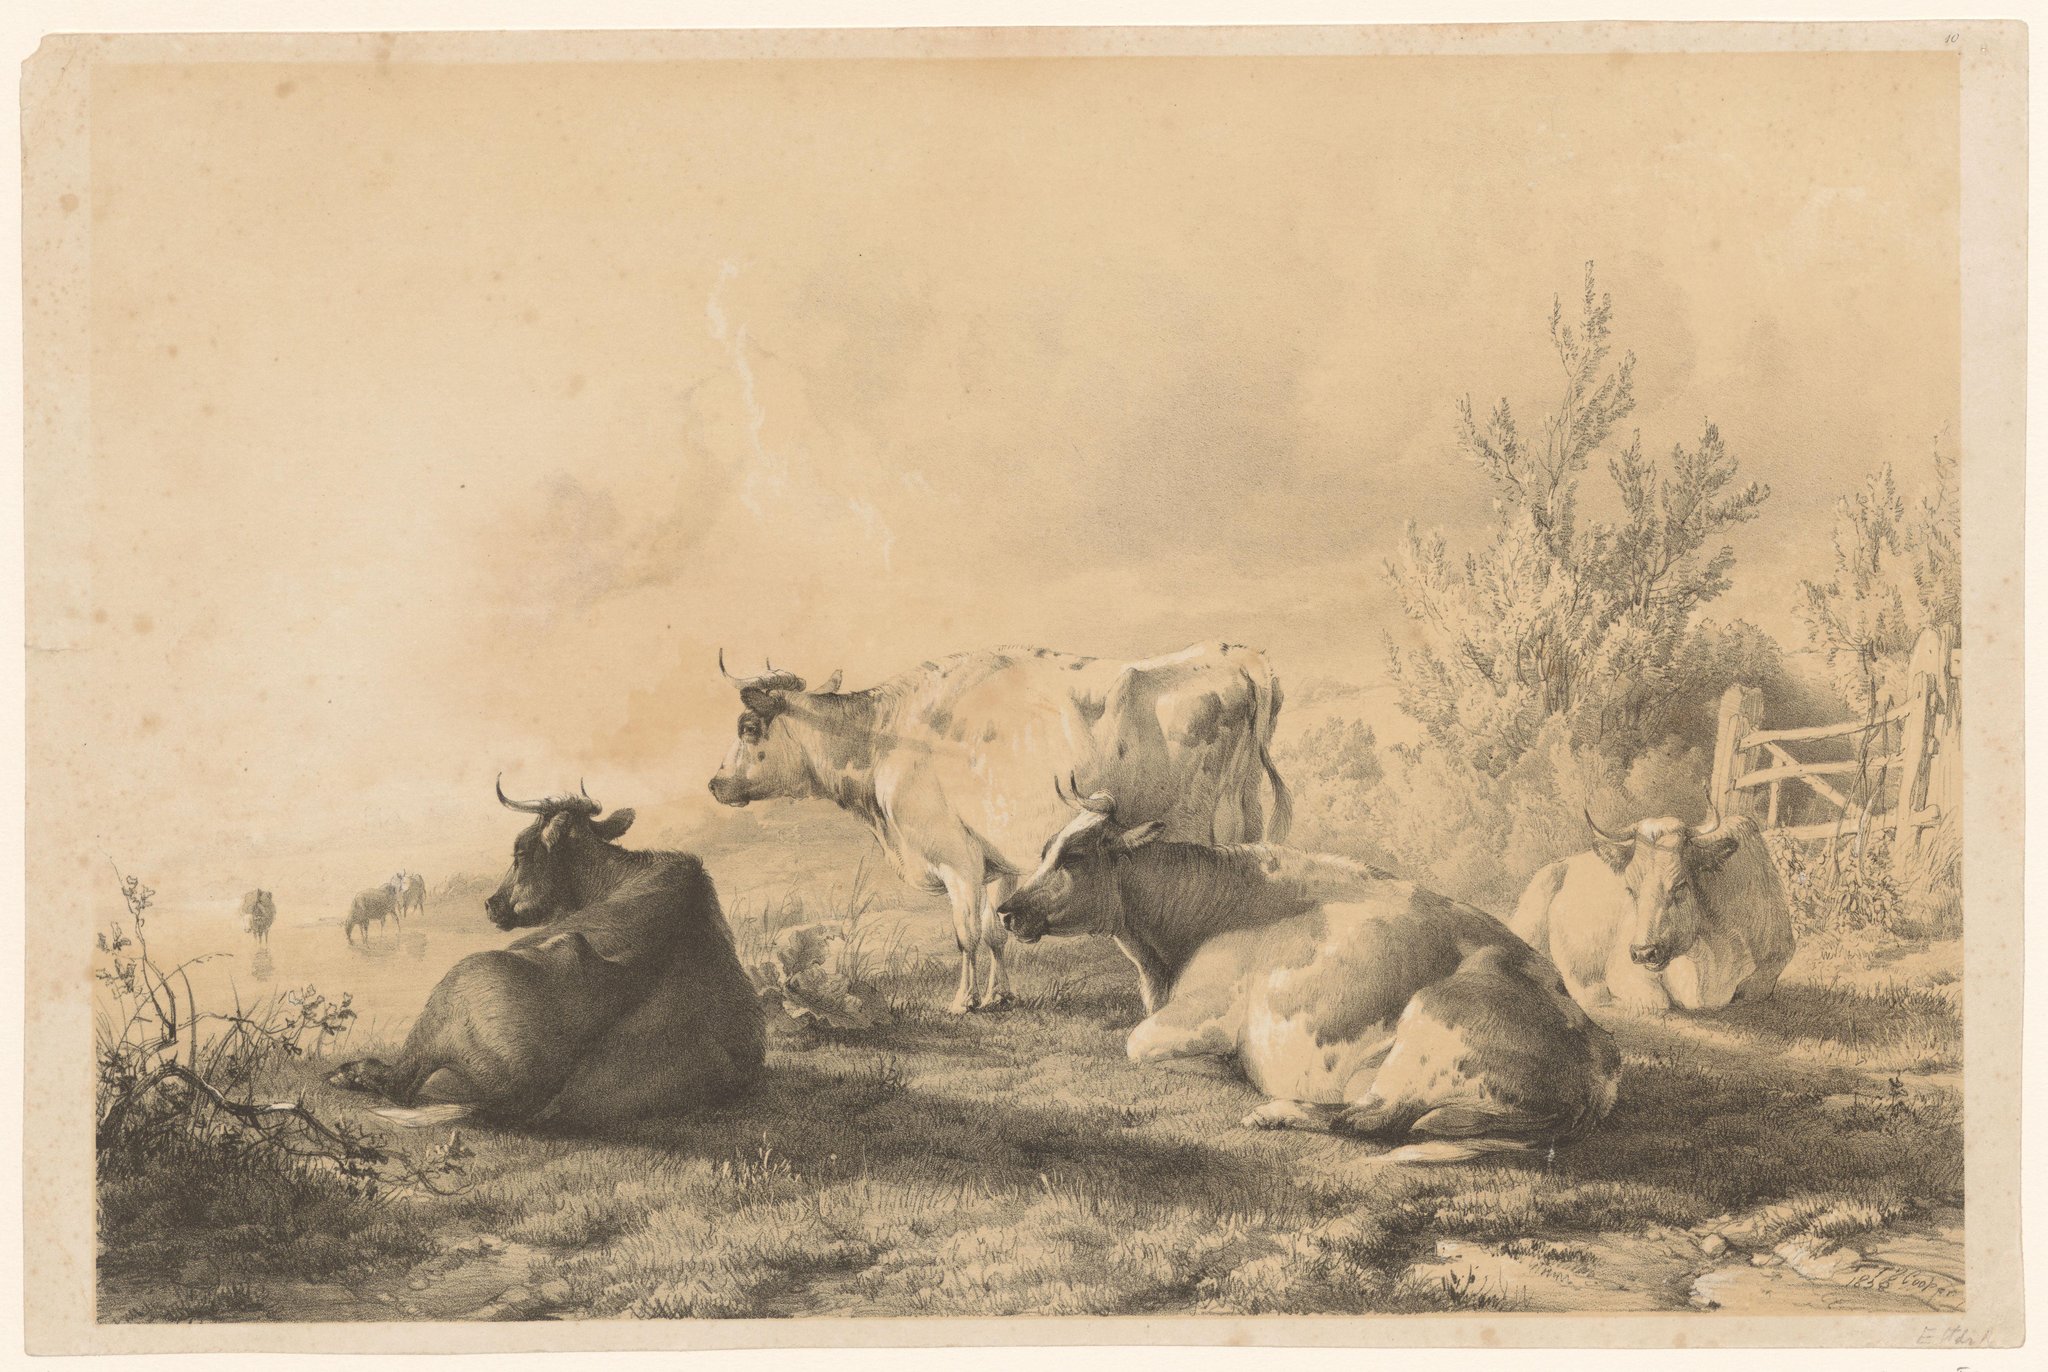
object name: print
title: Landschap met koeien aan een water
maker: thomas sidney cooper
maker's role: print maker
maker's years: 1803-1902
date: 1838-1839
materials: paper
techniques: tone lithography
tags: landscapes with waters, waterscapes, seascapes (in the temperate zone), bovine cattle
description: Prent maakt waarschijnlijk deel uit van de serie 'Groups of cattle, drawn from nature by T.S. Cooper 1839' gedrukt bij Hullmandel en in 1839 uitgegeven door Ackermann. De serie bestaat uit 26 prenten.